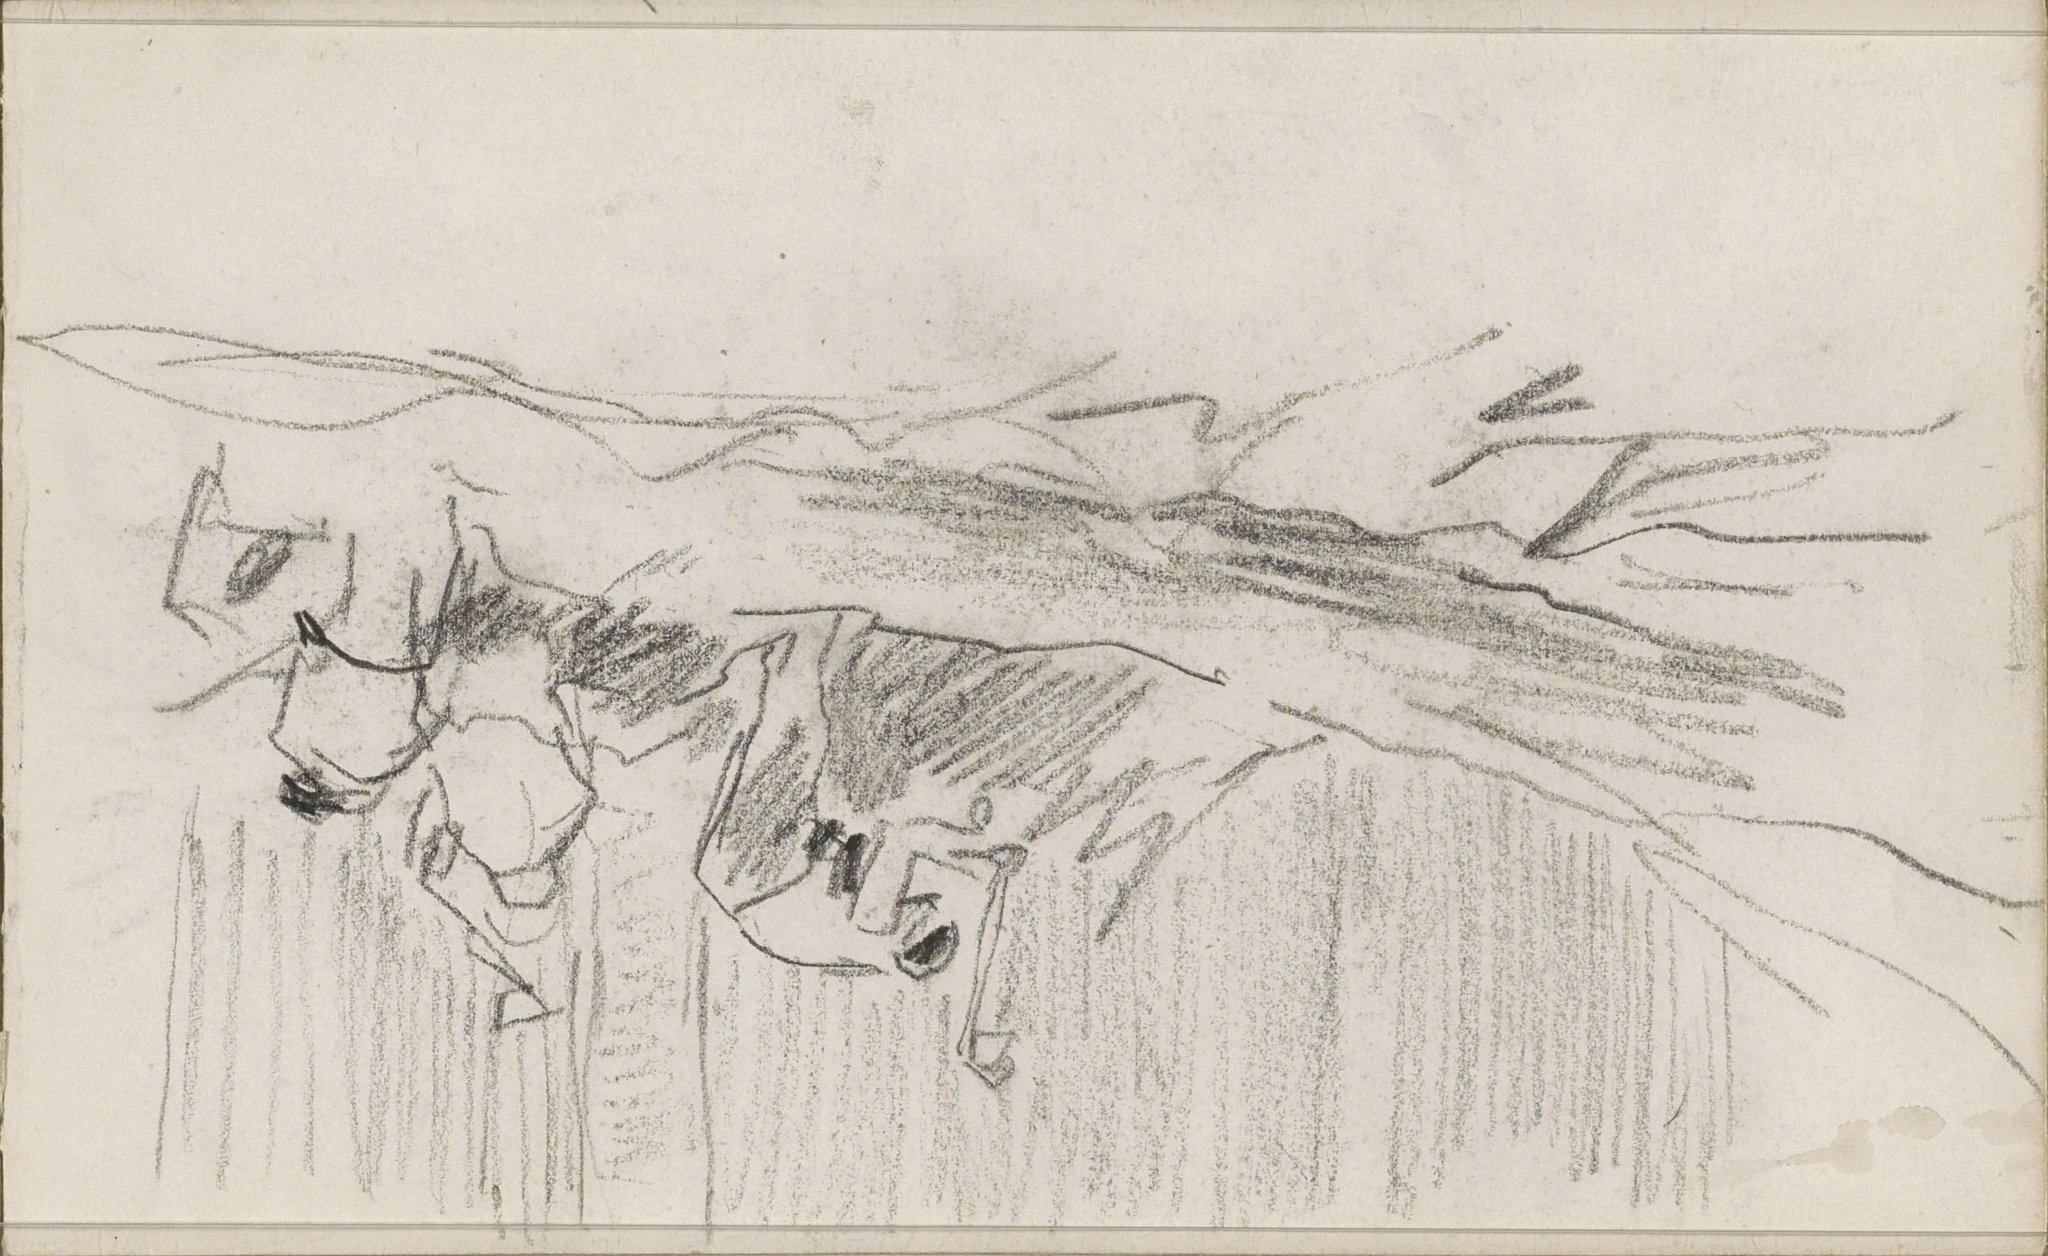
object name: sketchbook leaf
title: Houthakkers die een neergehaalde boom in stukken hakken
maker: anton mauve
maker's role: draughtsman, painter, print maker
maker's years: 1838-1888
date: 1848-1888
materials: chalk, paper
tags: woodcutting, woodcutter ~ forestry, trees (+ stem, trunk), tools, aids, implements ~ crafts and industries: axe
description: Blad 23 recto uit een schetsboek met 41 bladen.